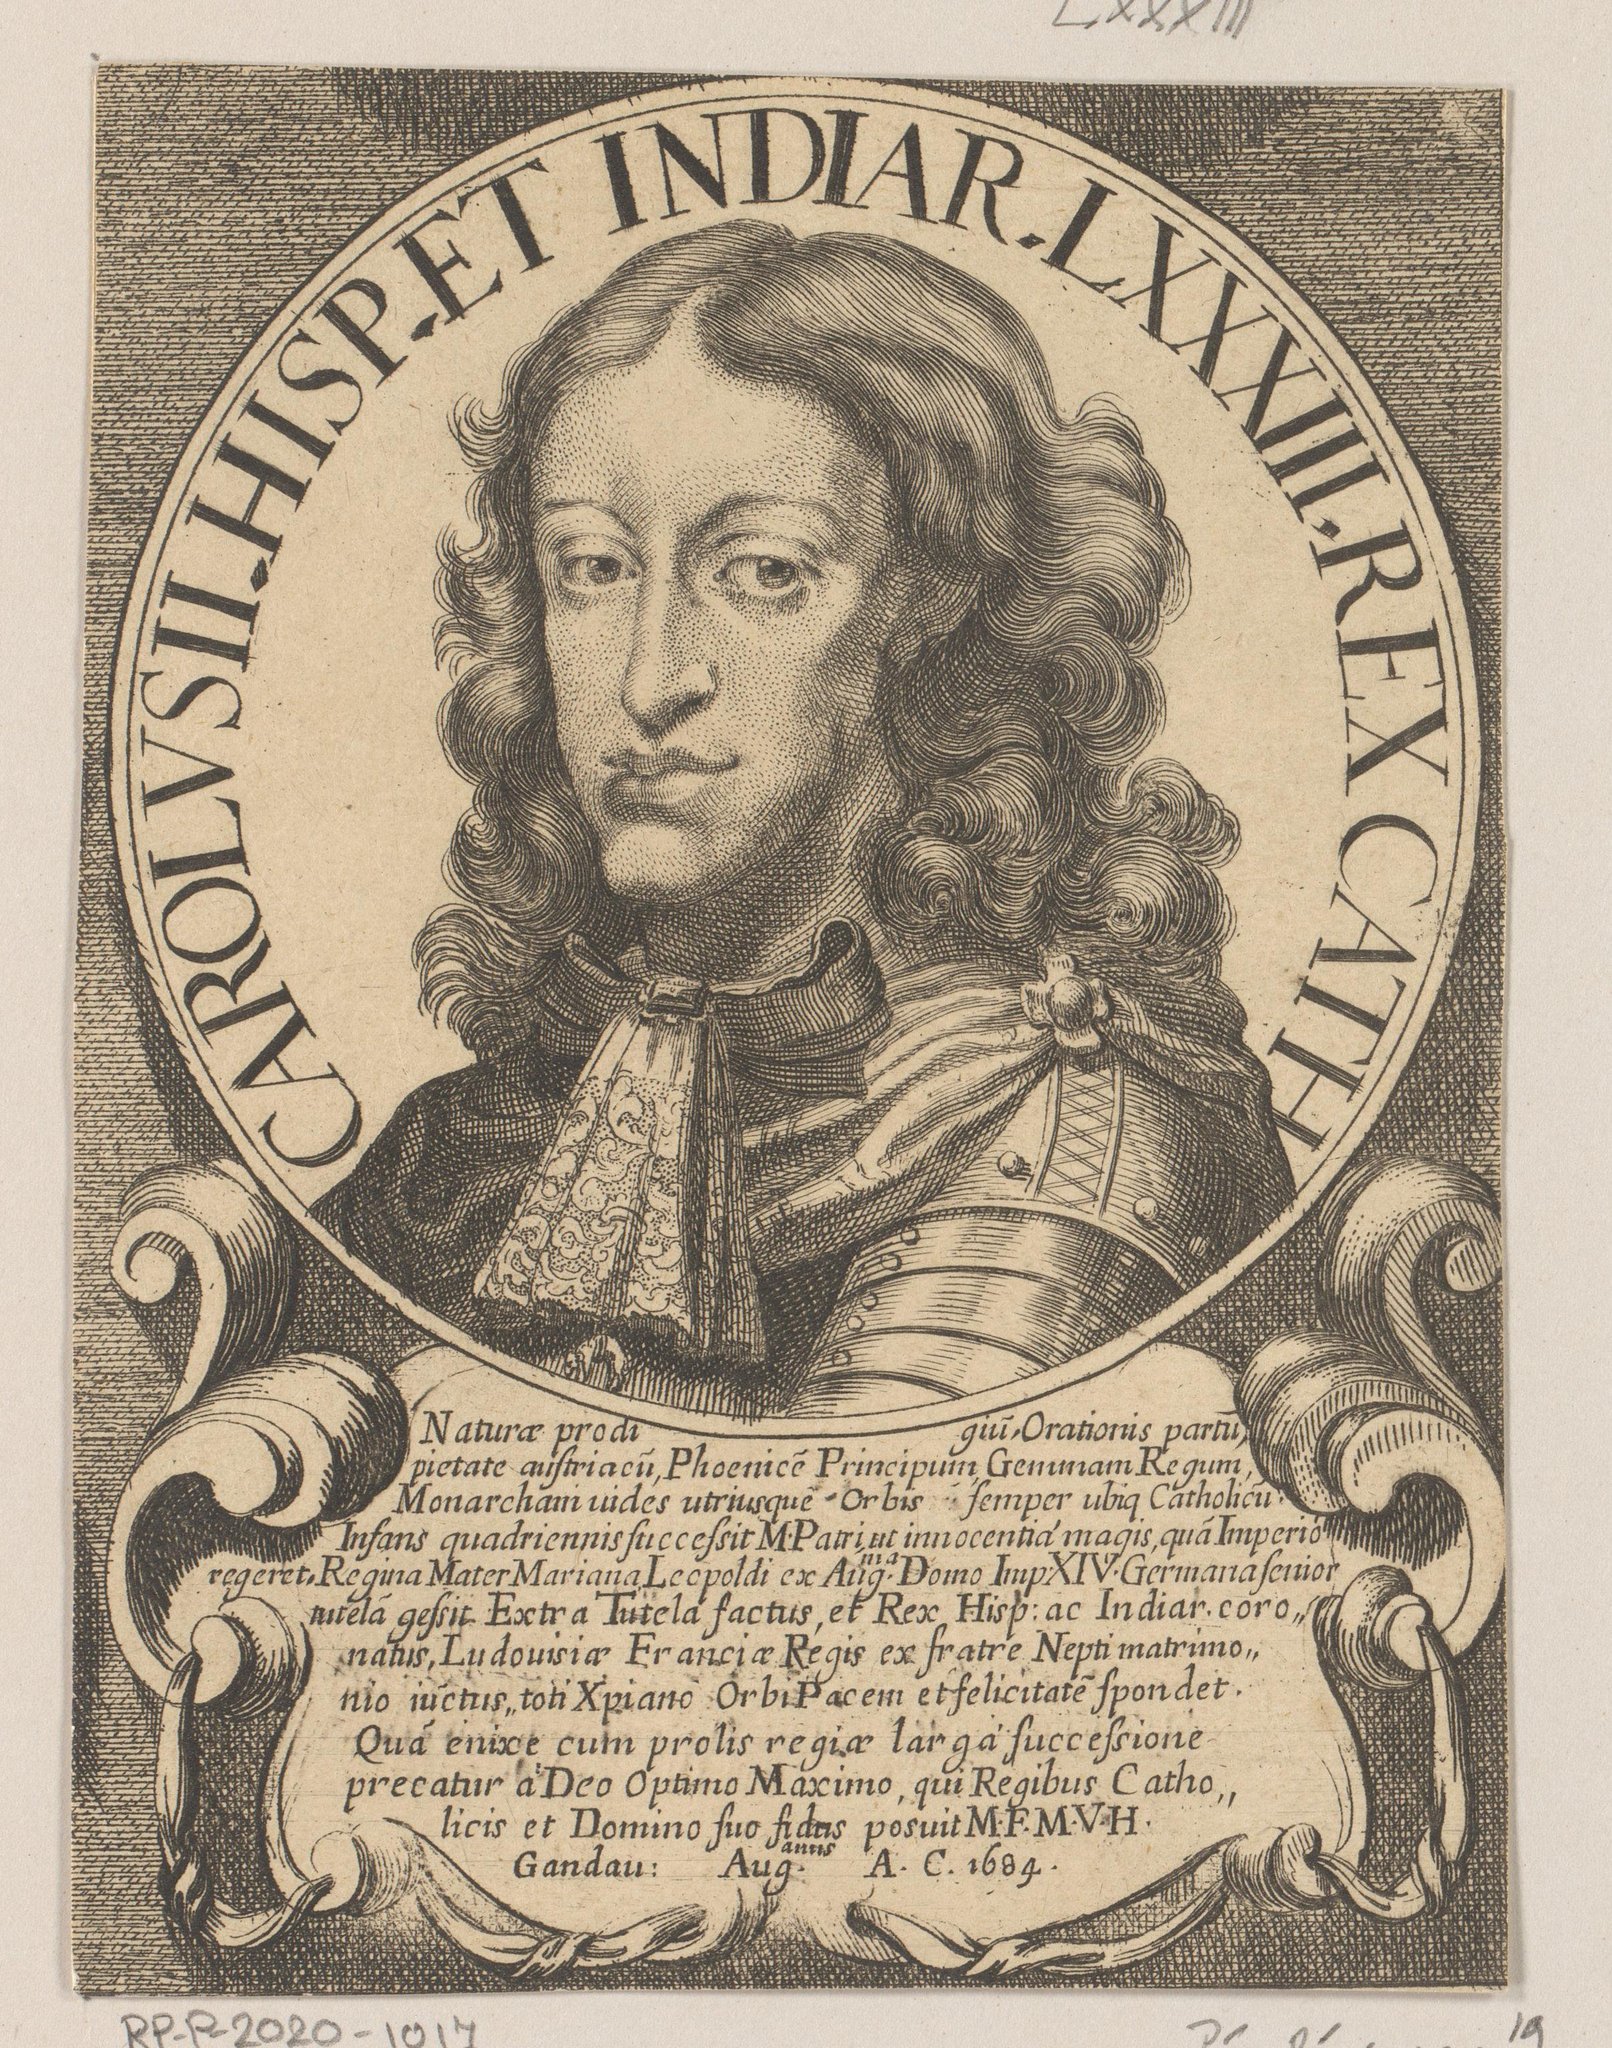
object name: print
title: Portret van Karel II, koning van Spanje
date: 1684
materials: paper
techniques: engraving, etching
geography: rome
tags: karel ii (koning van spanje), historical persons, ruler, sovereign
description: Portret mogelijk afkomstig van een grote prent, getiteld 'Effigies et series regum Hispaniae primum ex Gothis Christianorum (...)', bestaande uit meerdere bladen die samengevoegd konden worden, uitgegeven door Giovanni Giacomo de' Rossi in 1684.